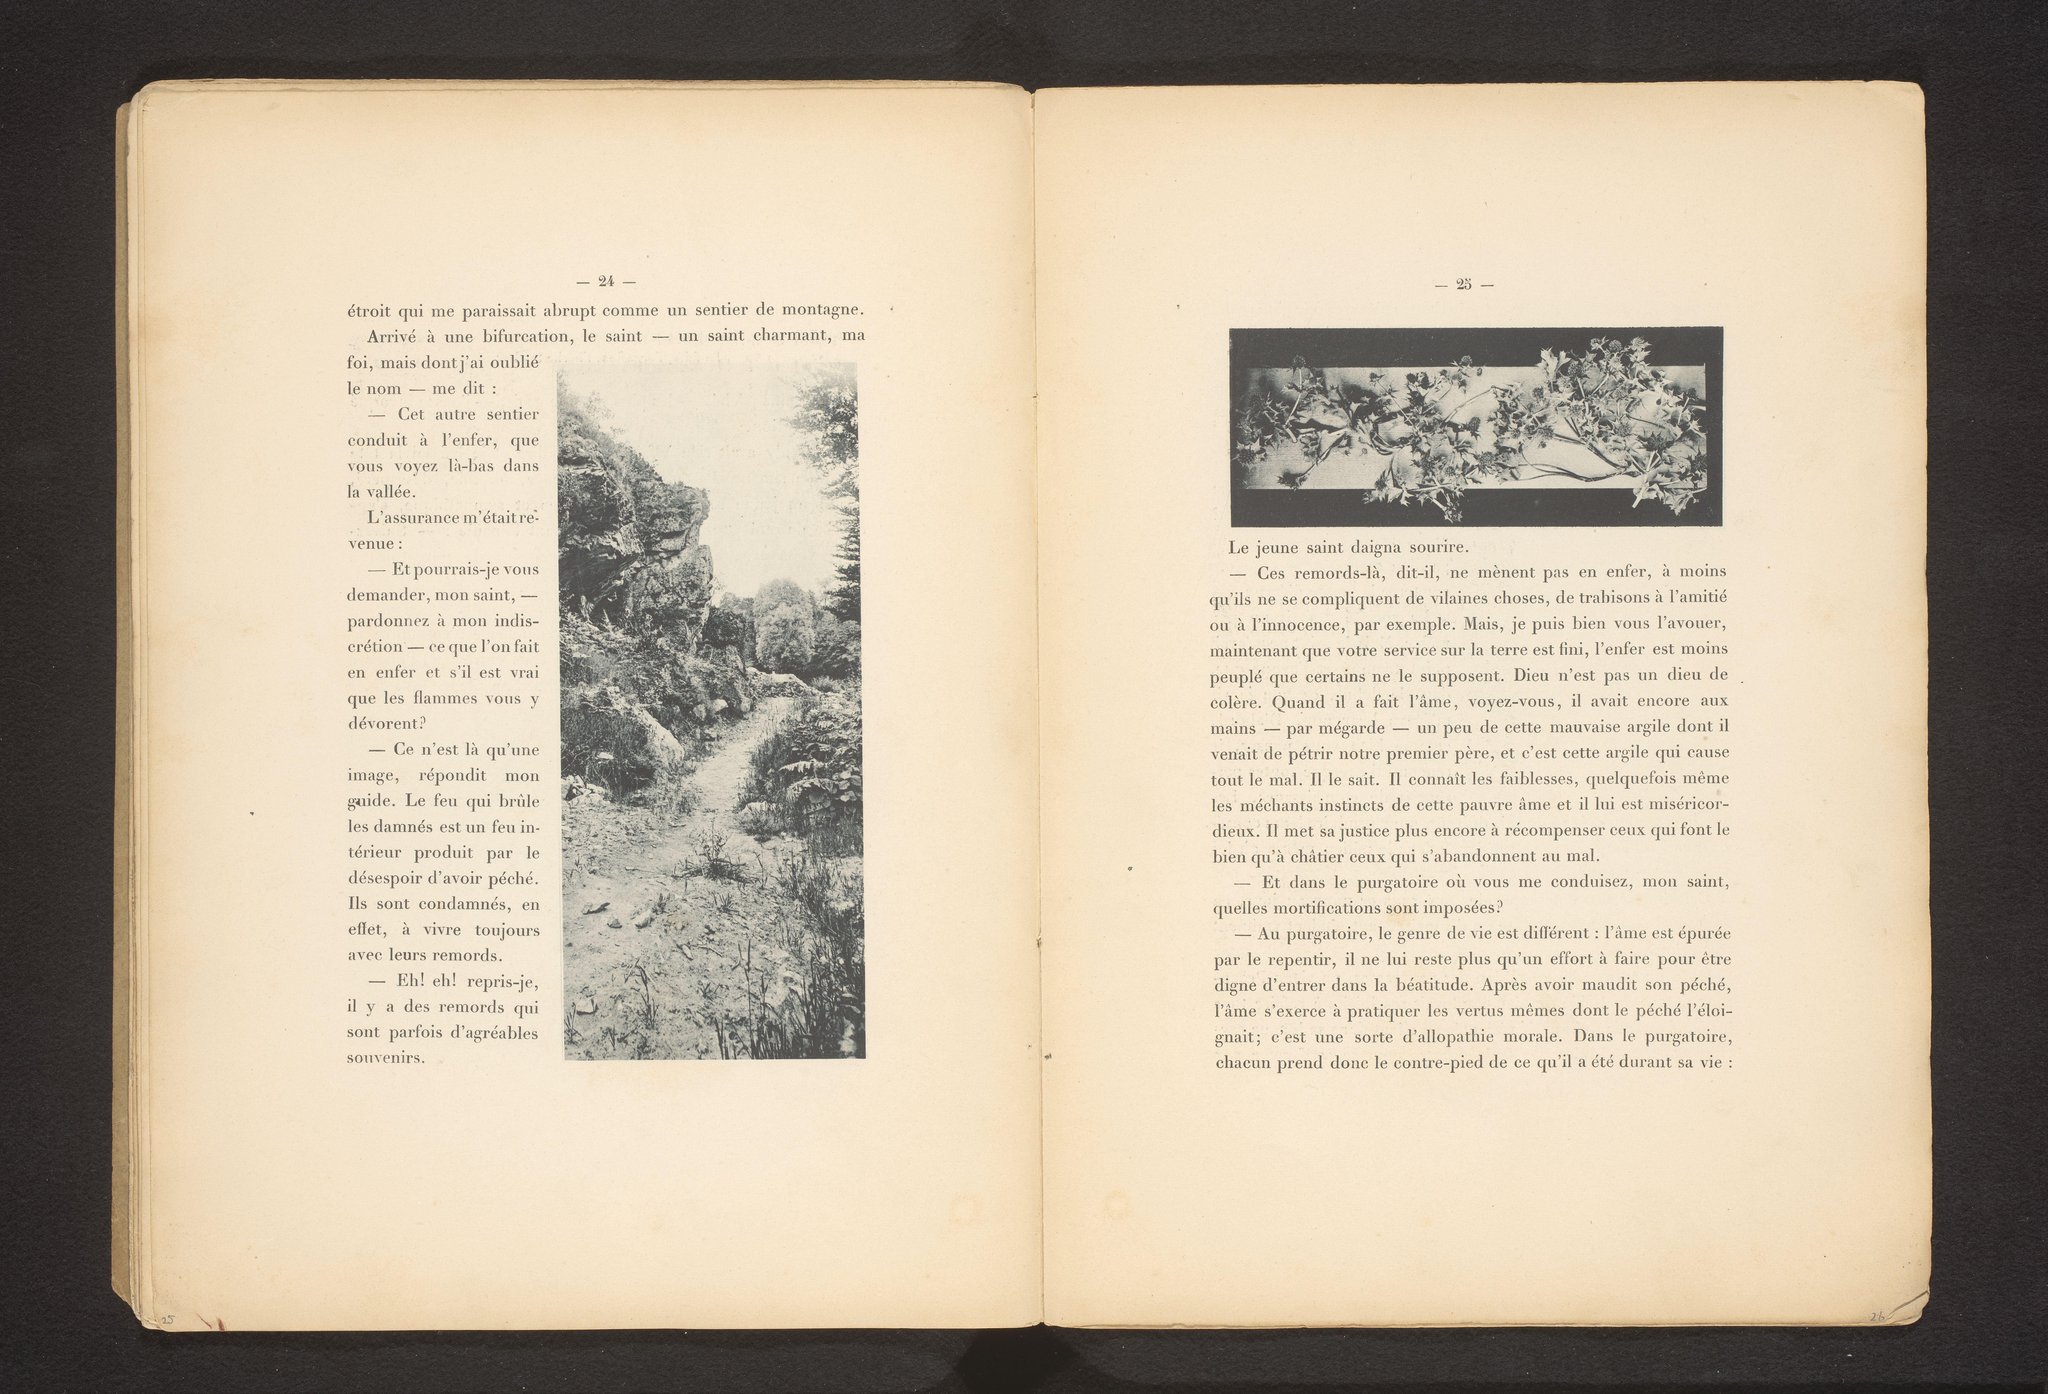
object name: photomechanical print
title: Takken van een distel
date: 1885-1895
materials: paper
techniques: photograph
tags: plants and herbs: thistle